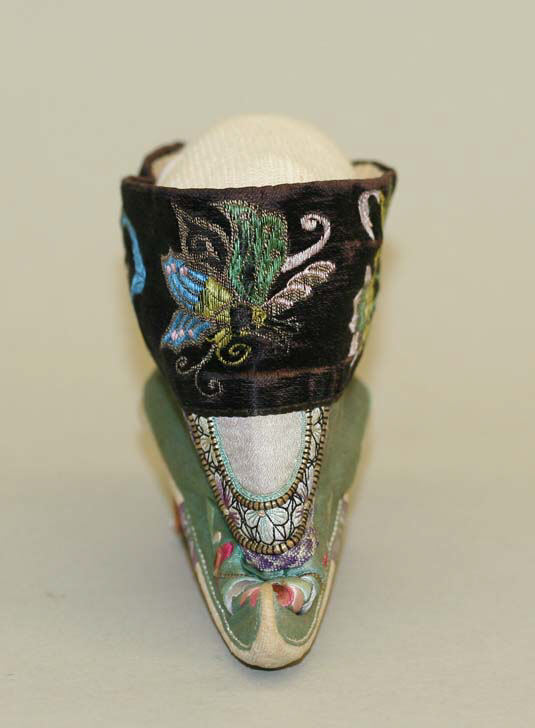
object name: shoe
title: Shoes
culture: chinese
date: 1867-1900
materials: fiber, metal, silk